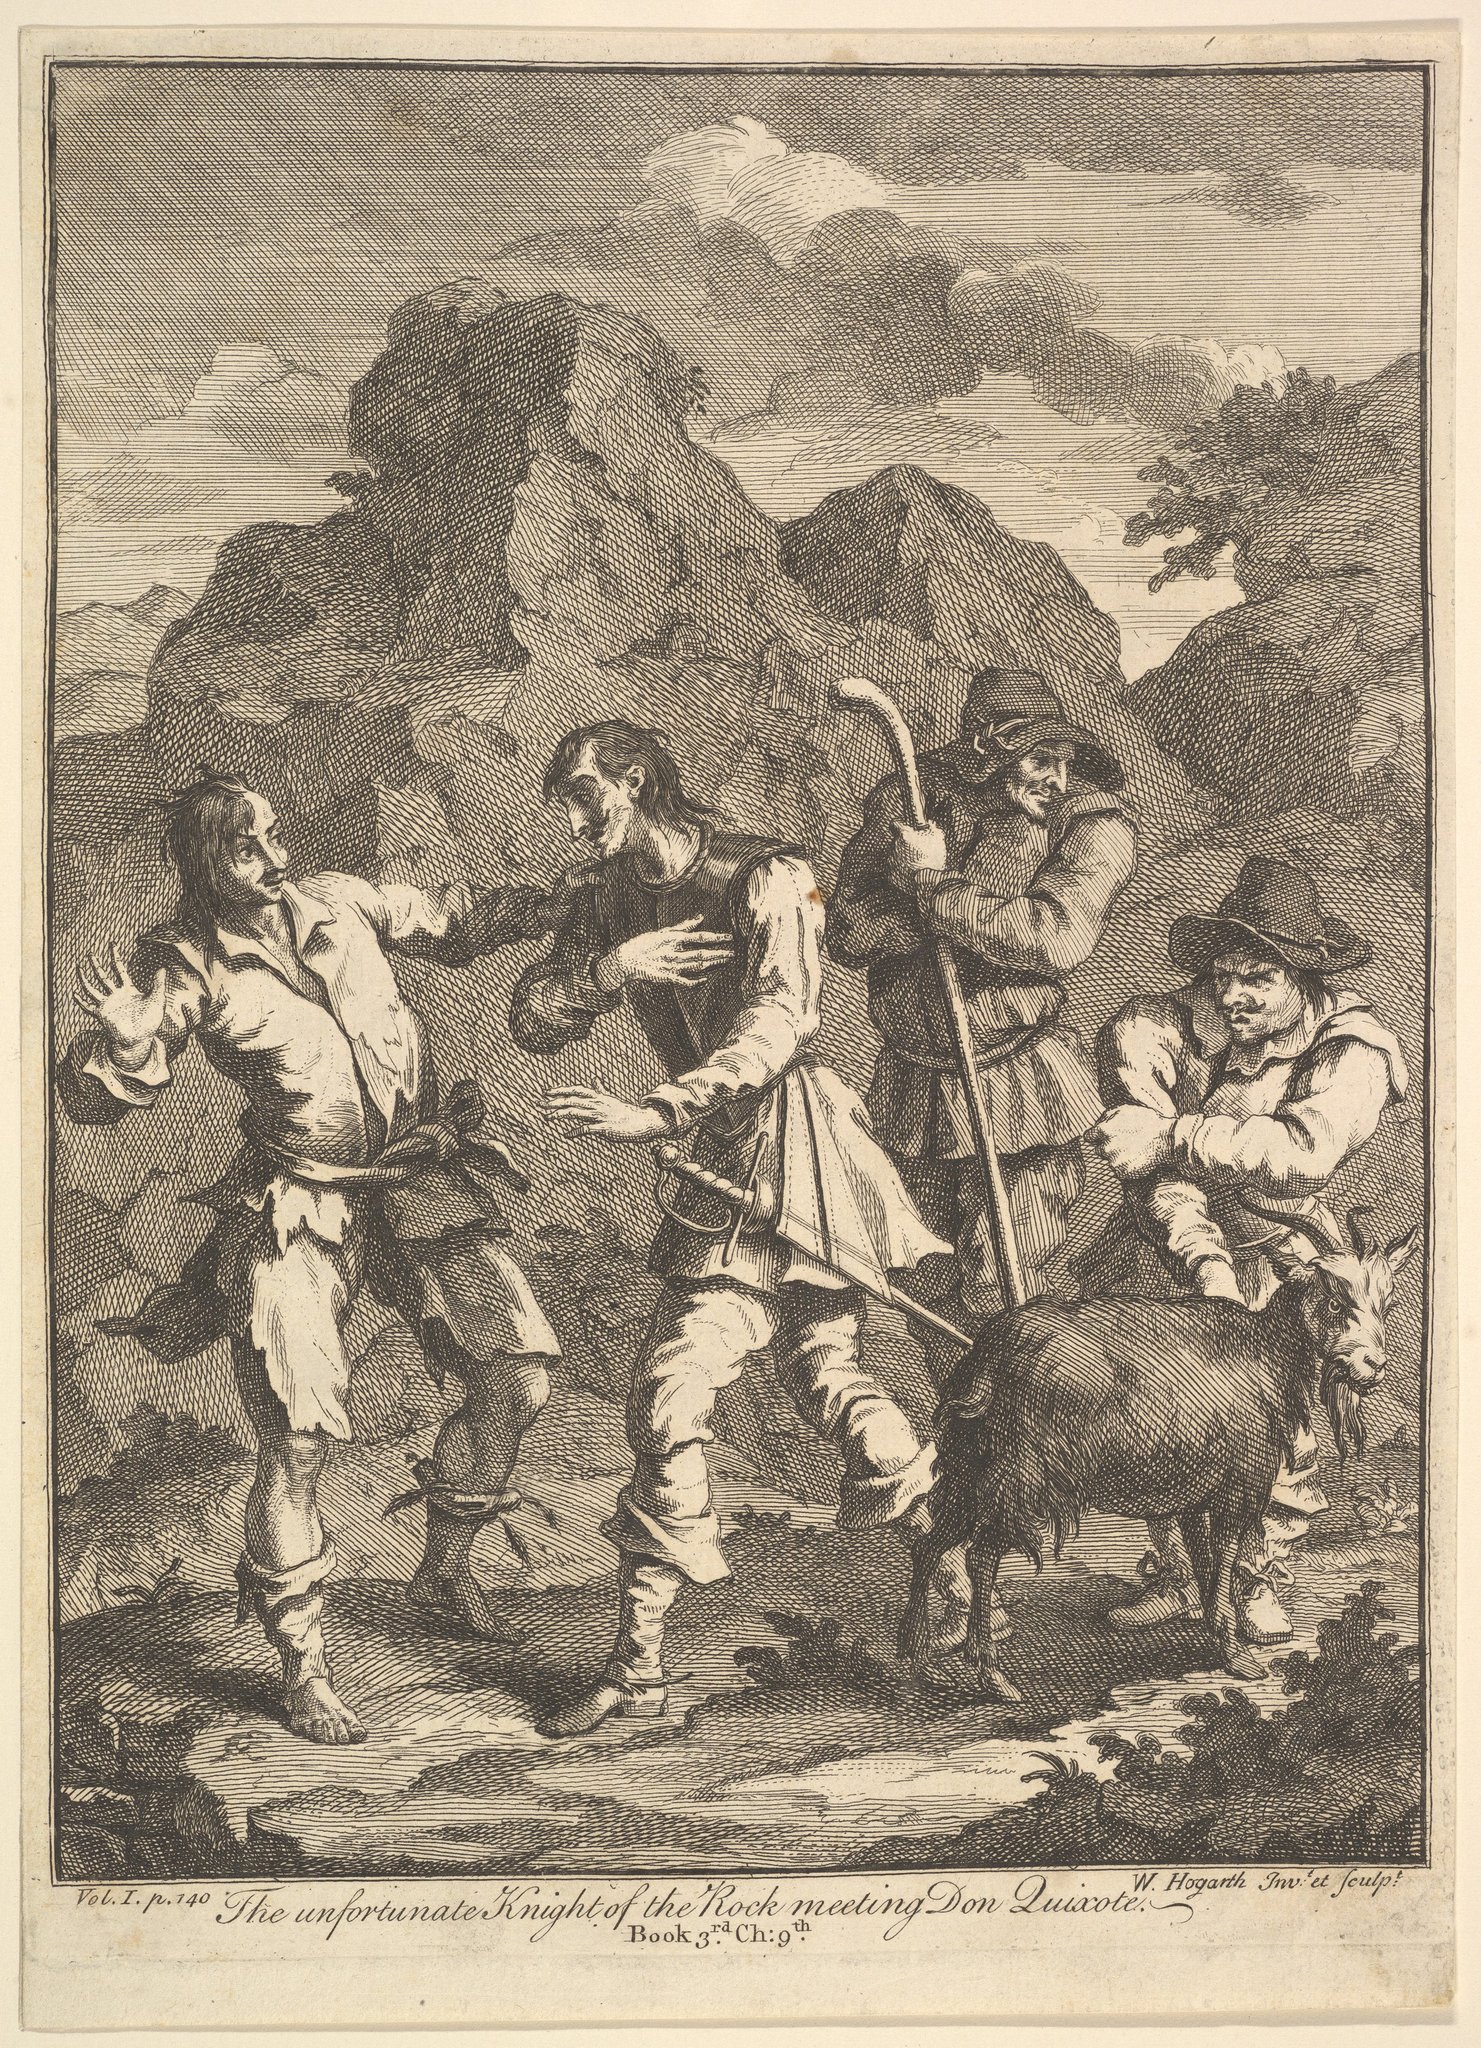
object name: print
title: Don Quixote and the Knight of the Rock (Six Illustrations for Don Quixote)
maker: william hogarth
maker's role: artist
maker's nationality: british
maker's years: 1697-1764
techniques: engraving, etching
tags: men,goats,don quixote